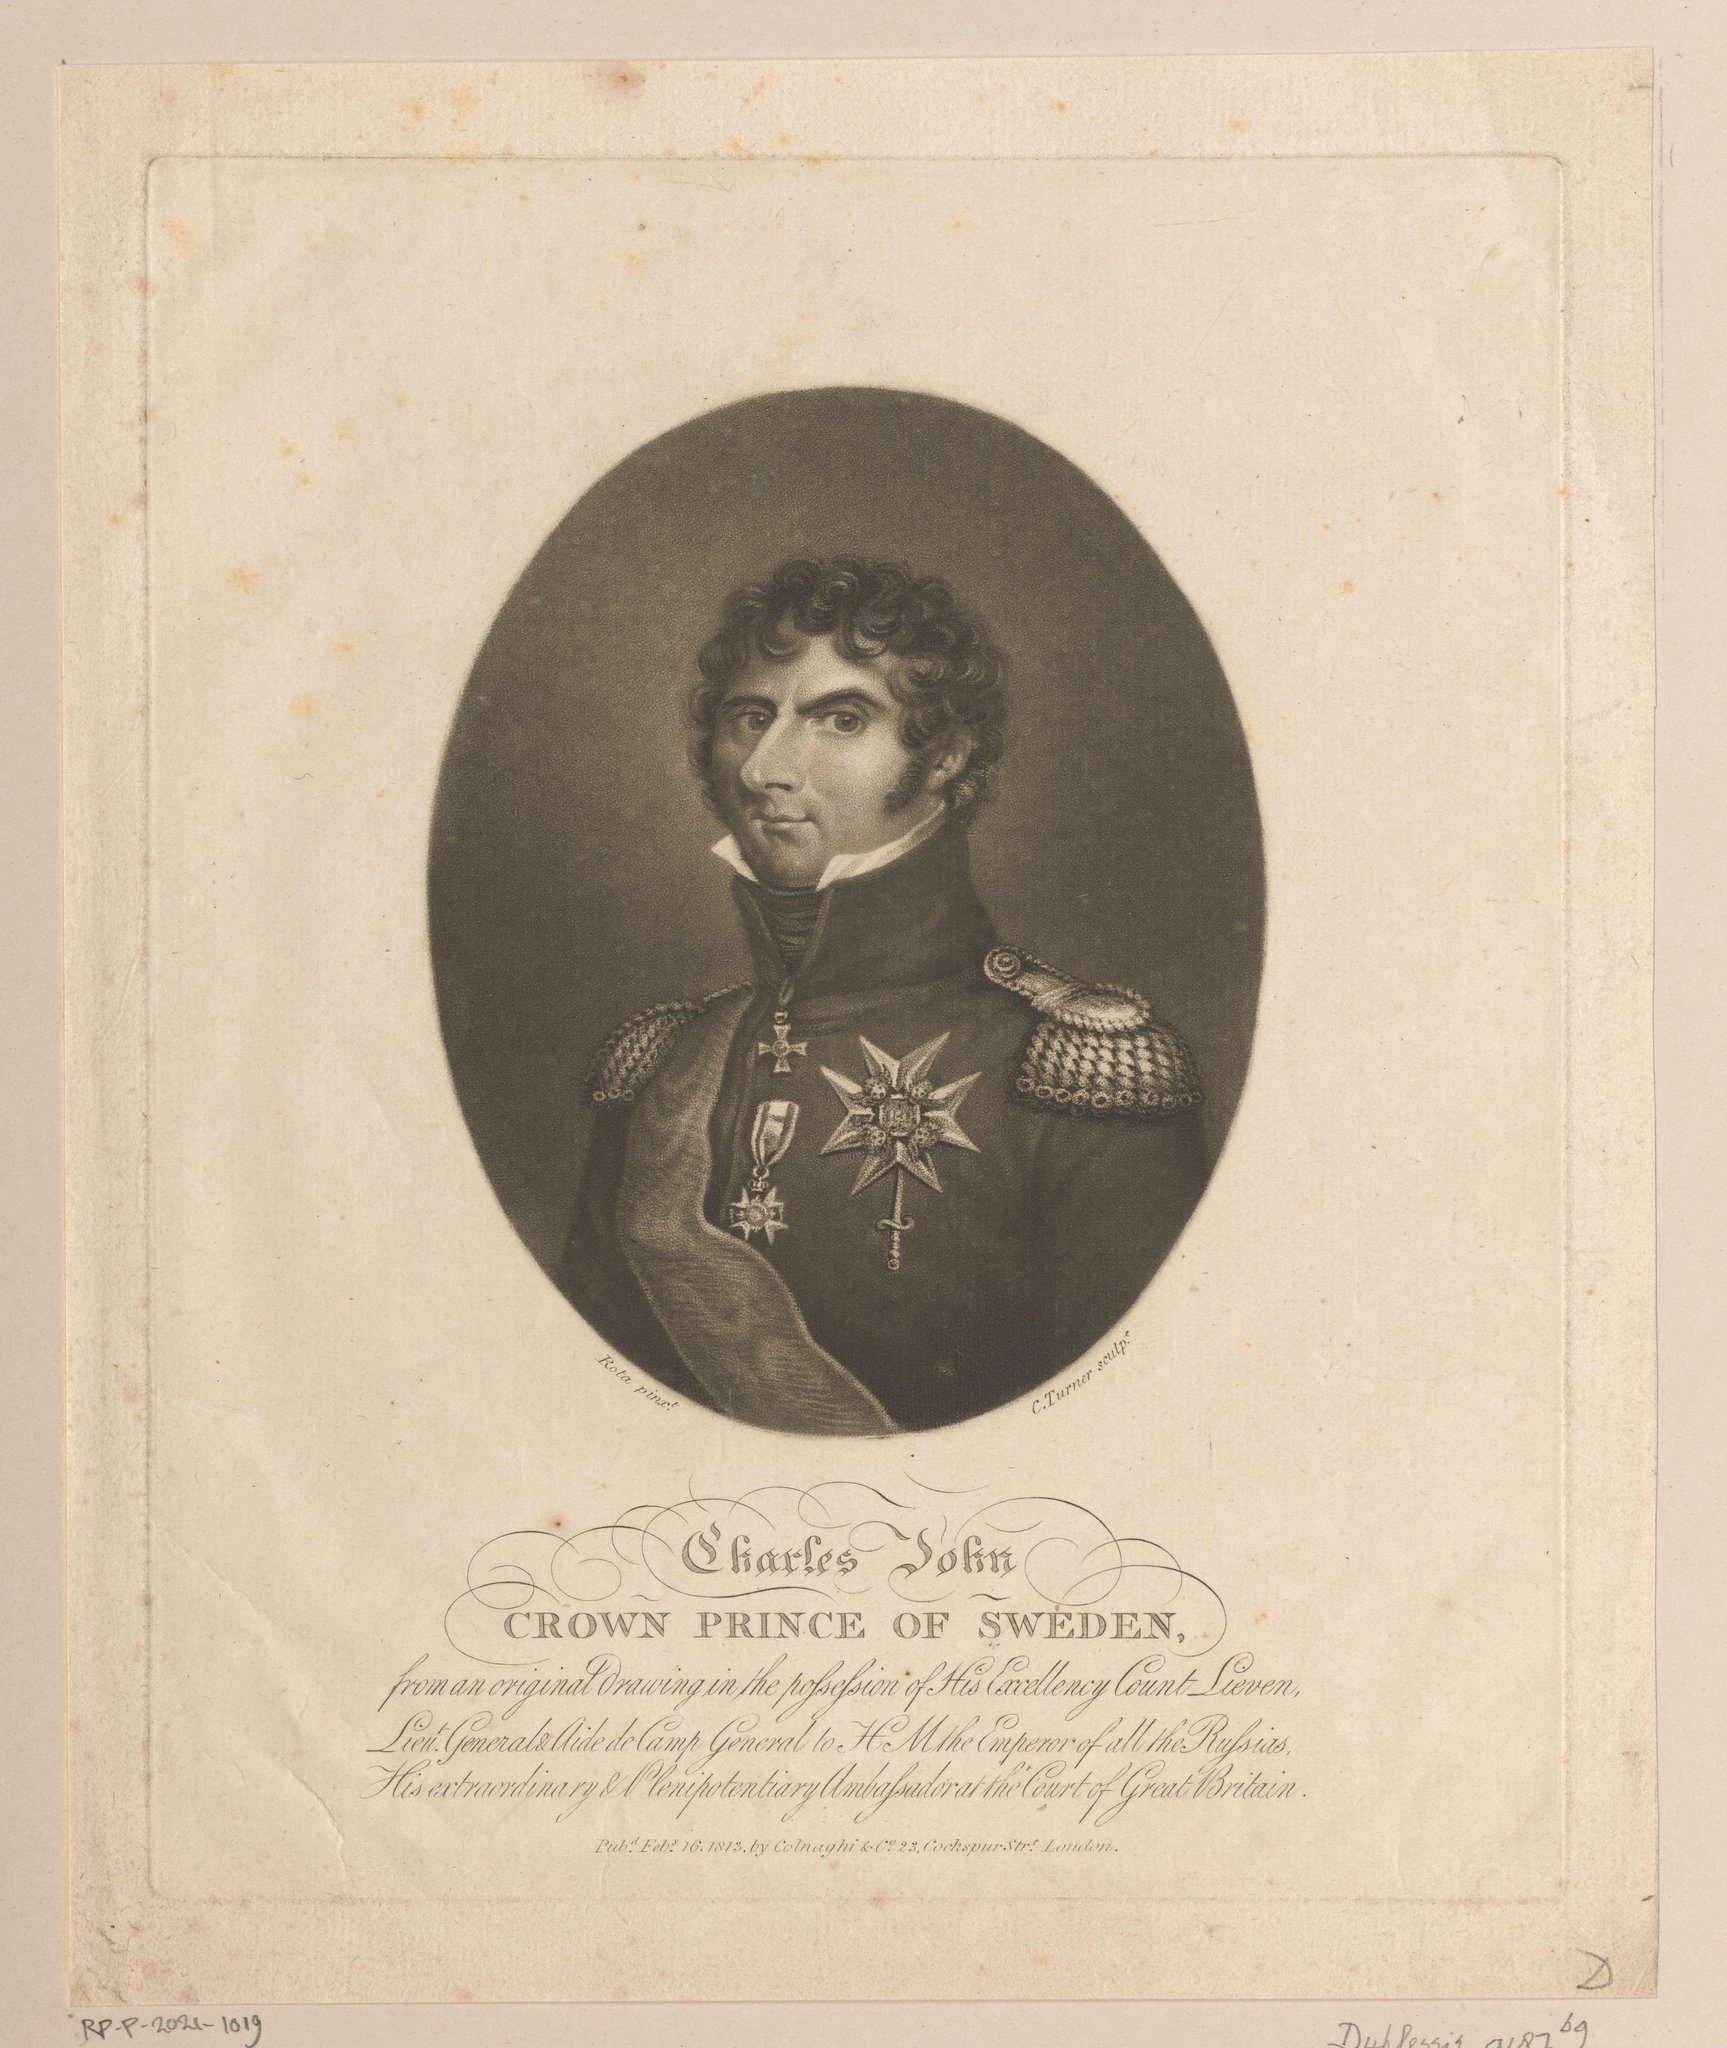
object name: print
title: Portret van Karel Johan, kroonprins van Zweden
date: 1812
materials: paper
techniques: engraving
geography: london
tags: historical persons, medals and other marks of military honour, crown prince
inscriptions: date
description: Portret van Karel Johan, kroonprins van Zweden de latere Karel XIV Johan, koning van Zweden en Noorwegen.